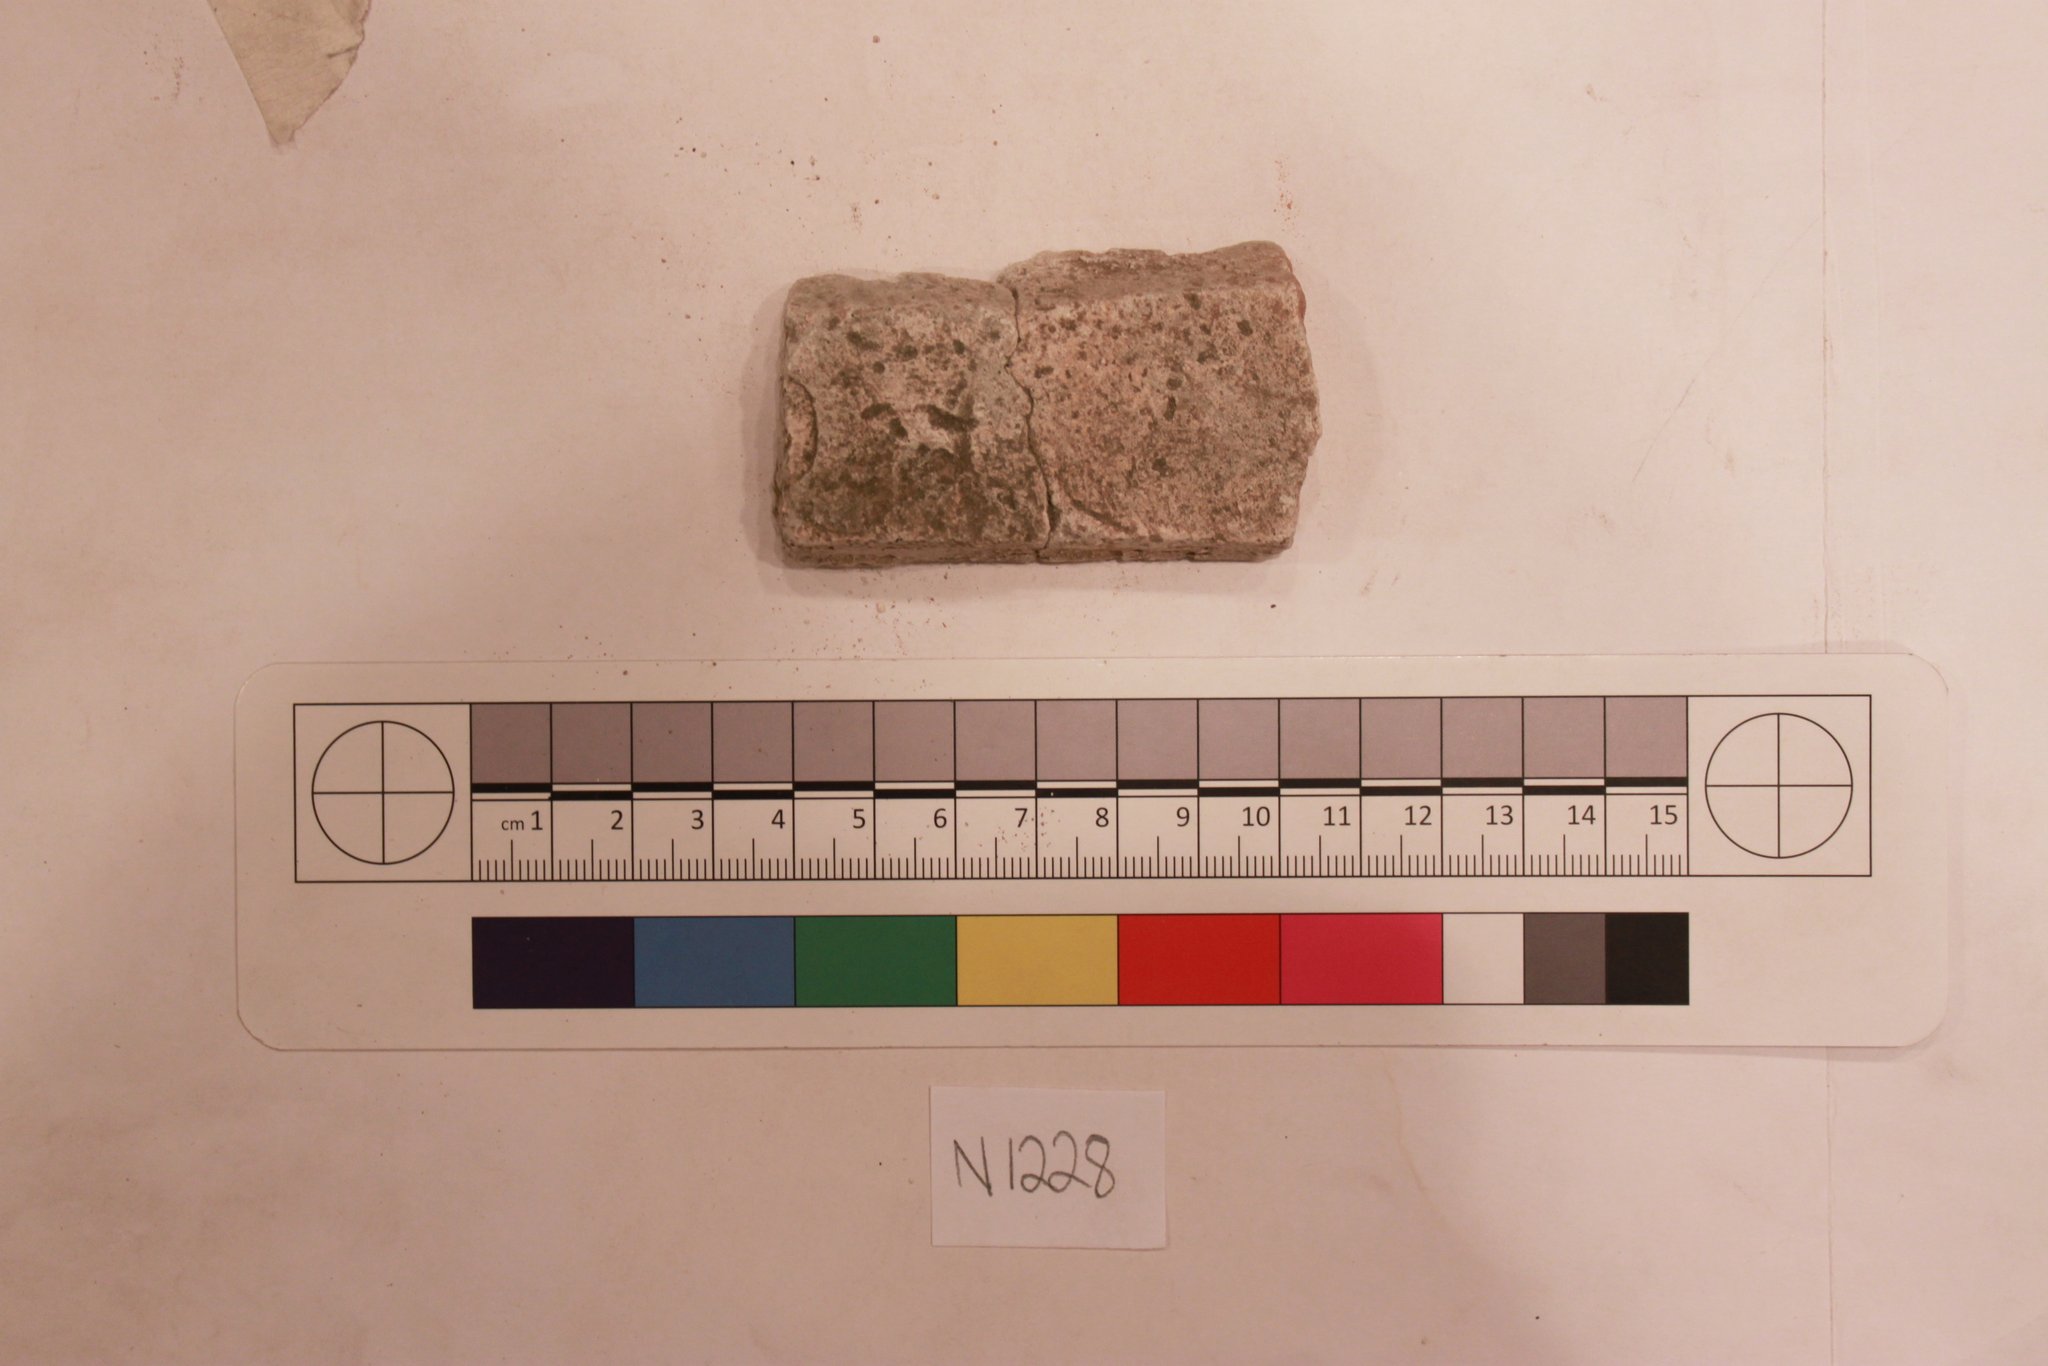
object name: fragment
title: Stucco Fragment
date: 701-1200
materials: plaster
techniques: carving, painting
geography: iran